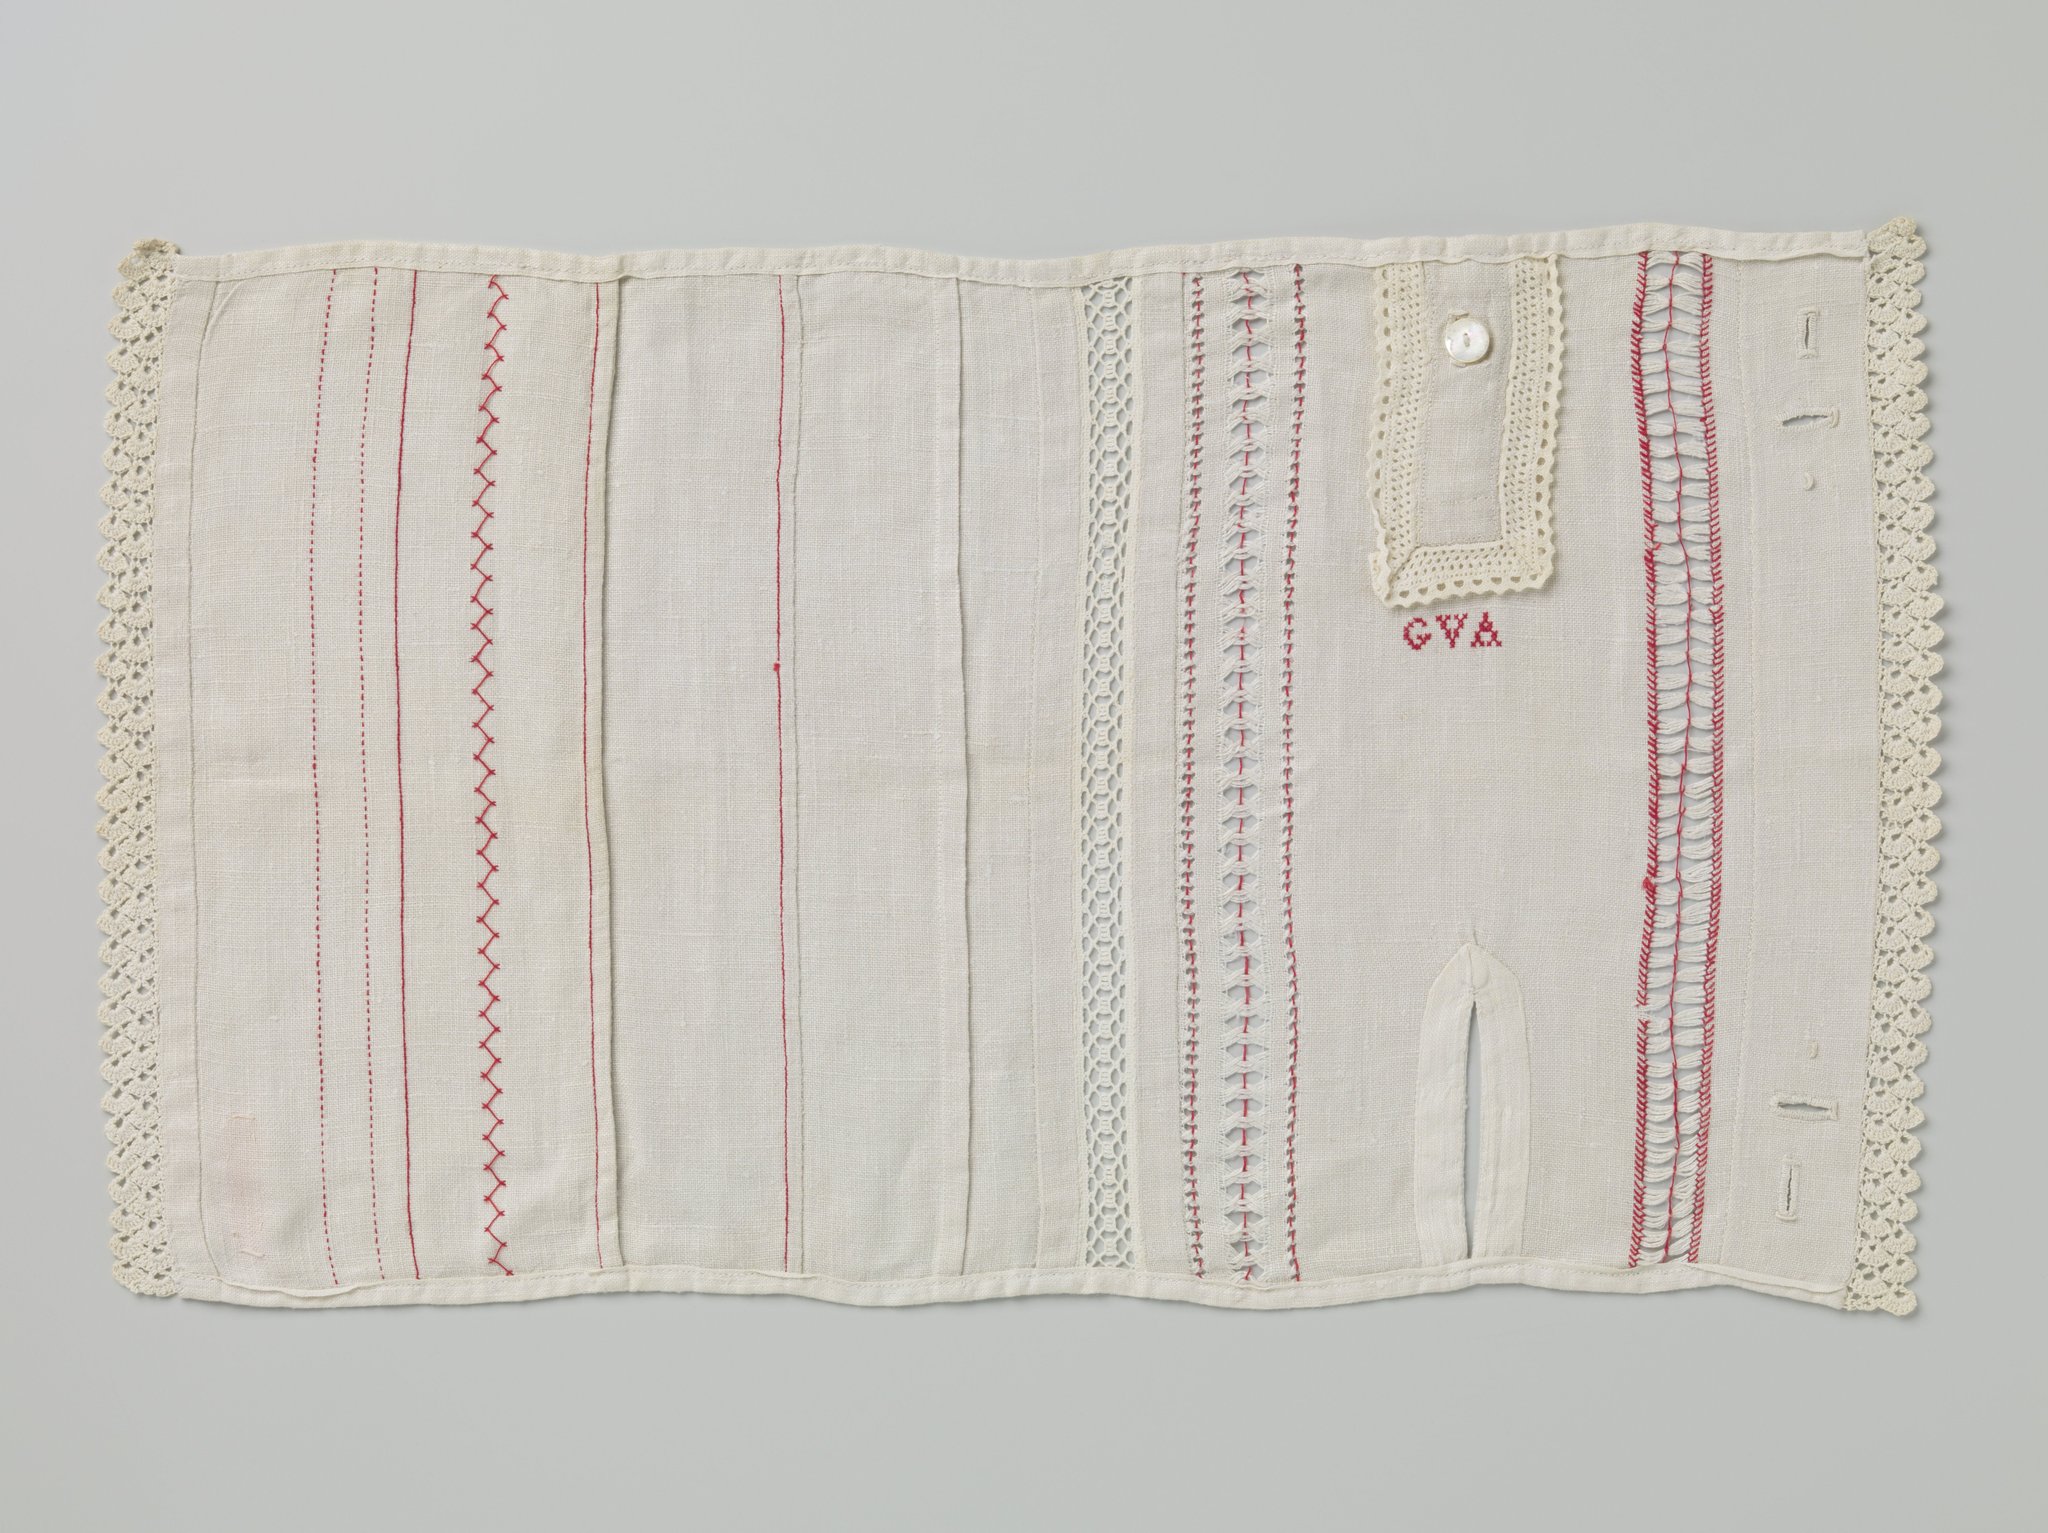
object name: naaiwerk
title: Naden- en stukkenlap van linnen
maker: geertruide van akkeren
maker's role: borduurster, linnennaaister, naaister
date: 1910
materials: linen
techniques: embroidered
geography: amsterdam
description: Naden- en stukkenlap van linnen en rode DMC. Het borduurwerk heeft de initialen GVA, Amsterdam en de tekst Geertruide van Akkeren.